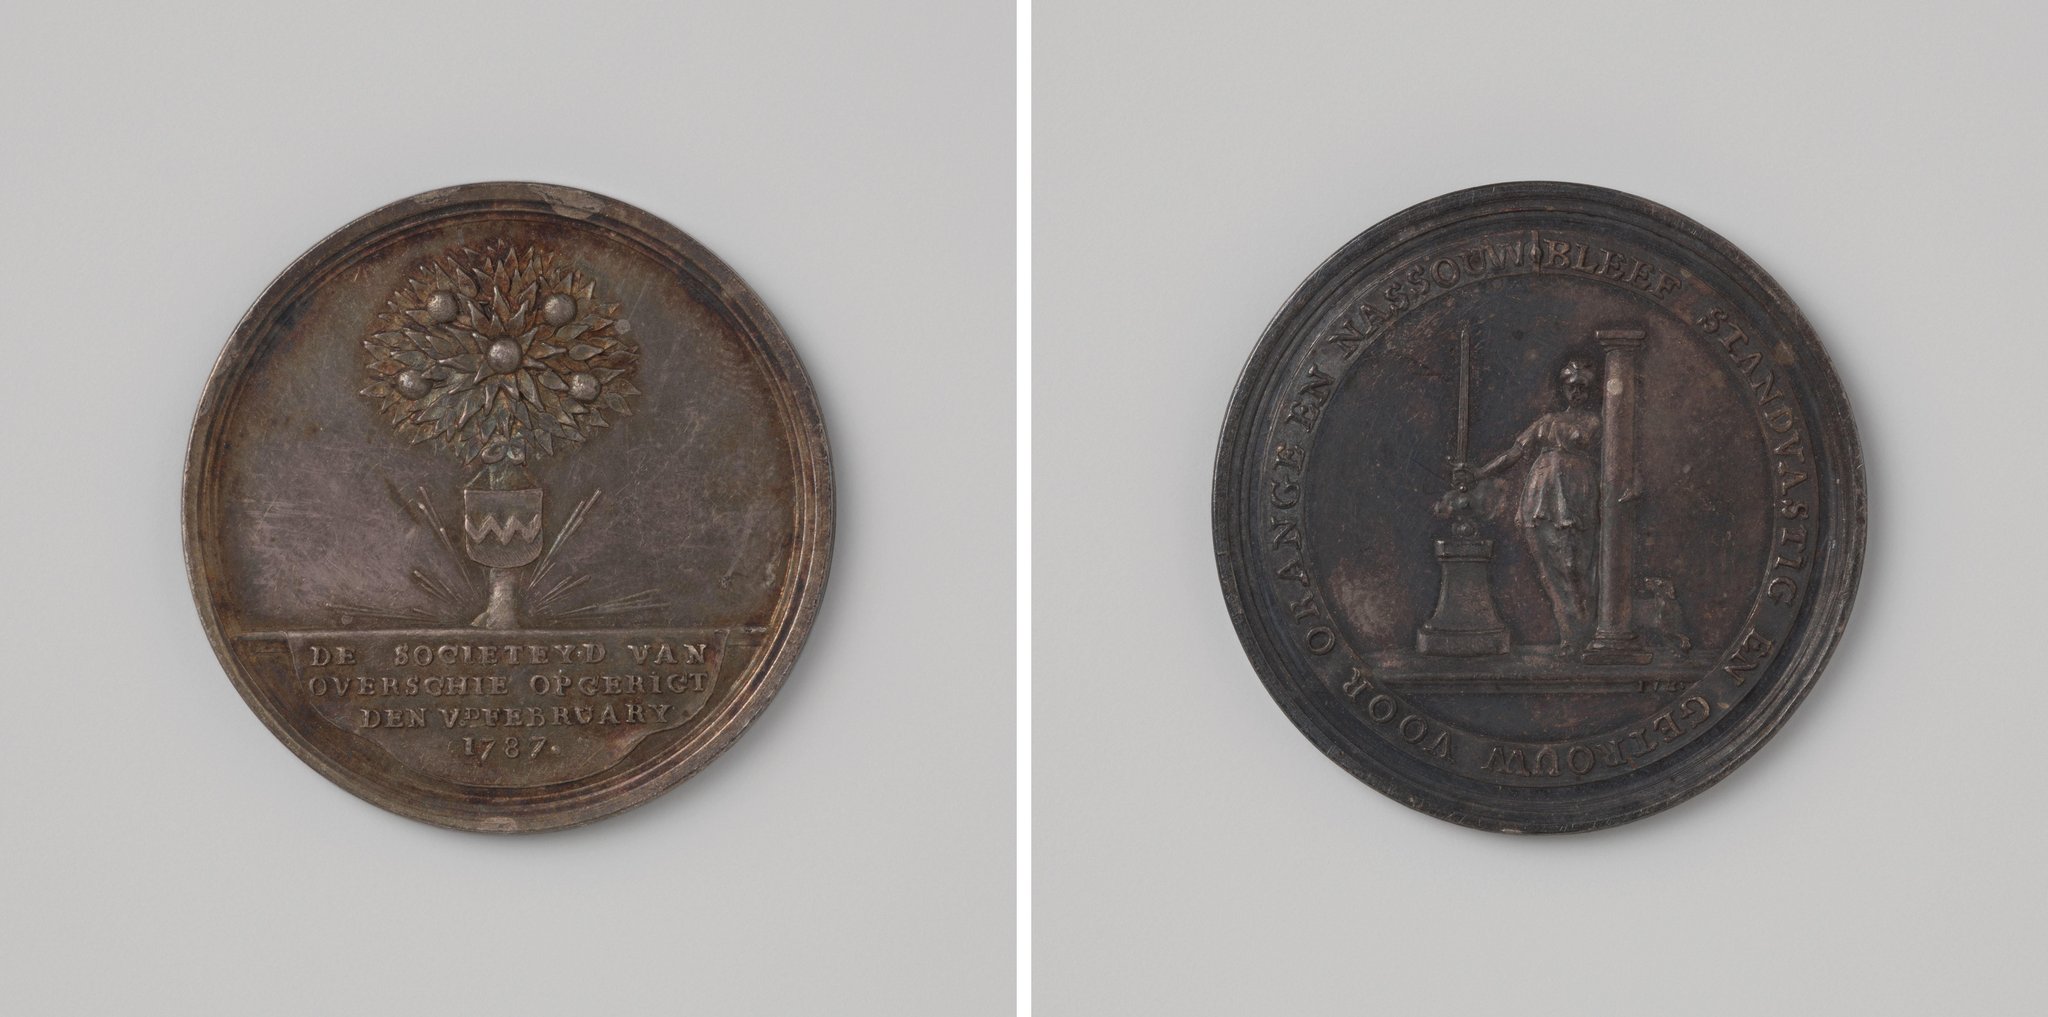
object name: history medal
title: Oprichting van de Oranje-societeit te Overschie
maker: Anonymous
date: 1787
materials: silver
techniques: striking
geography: netherlands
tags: overschie